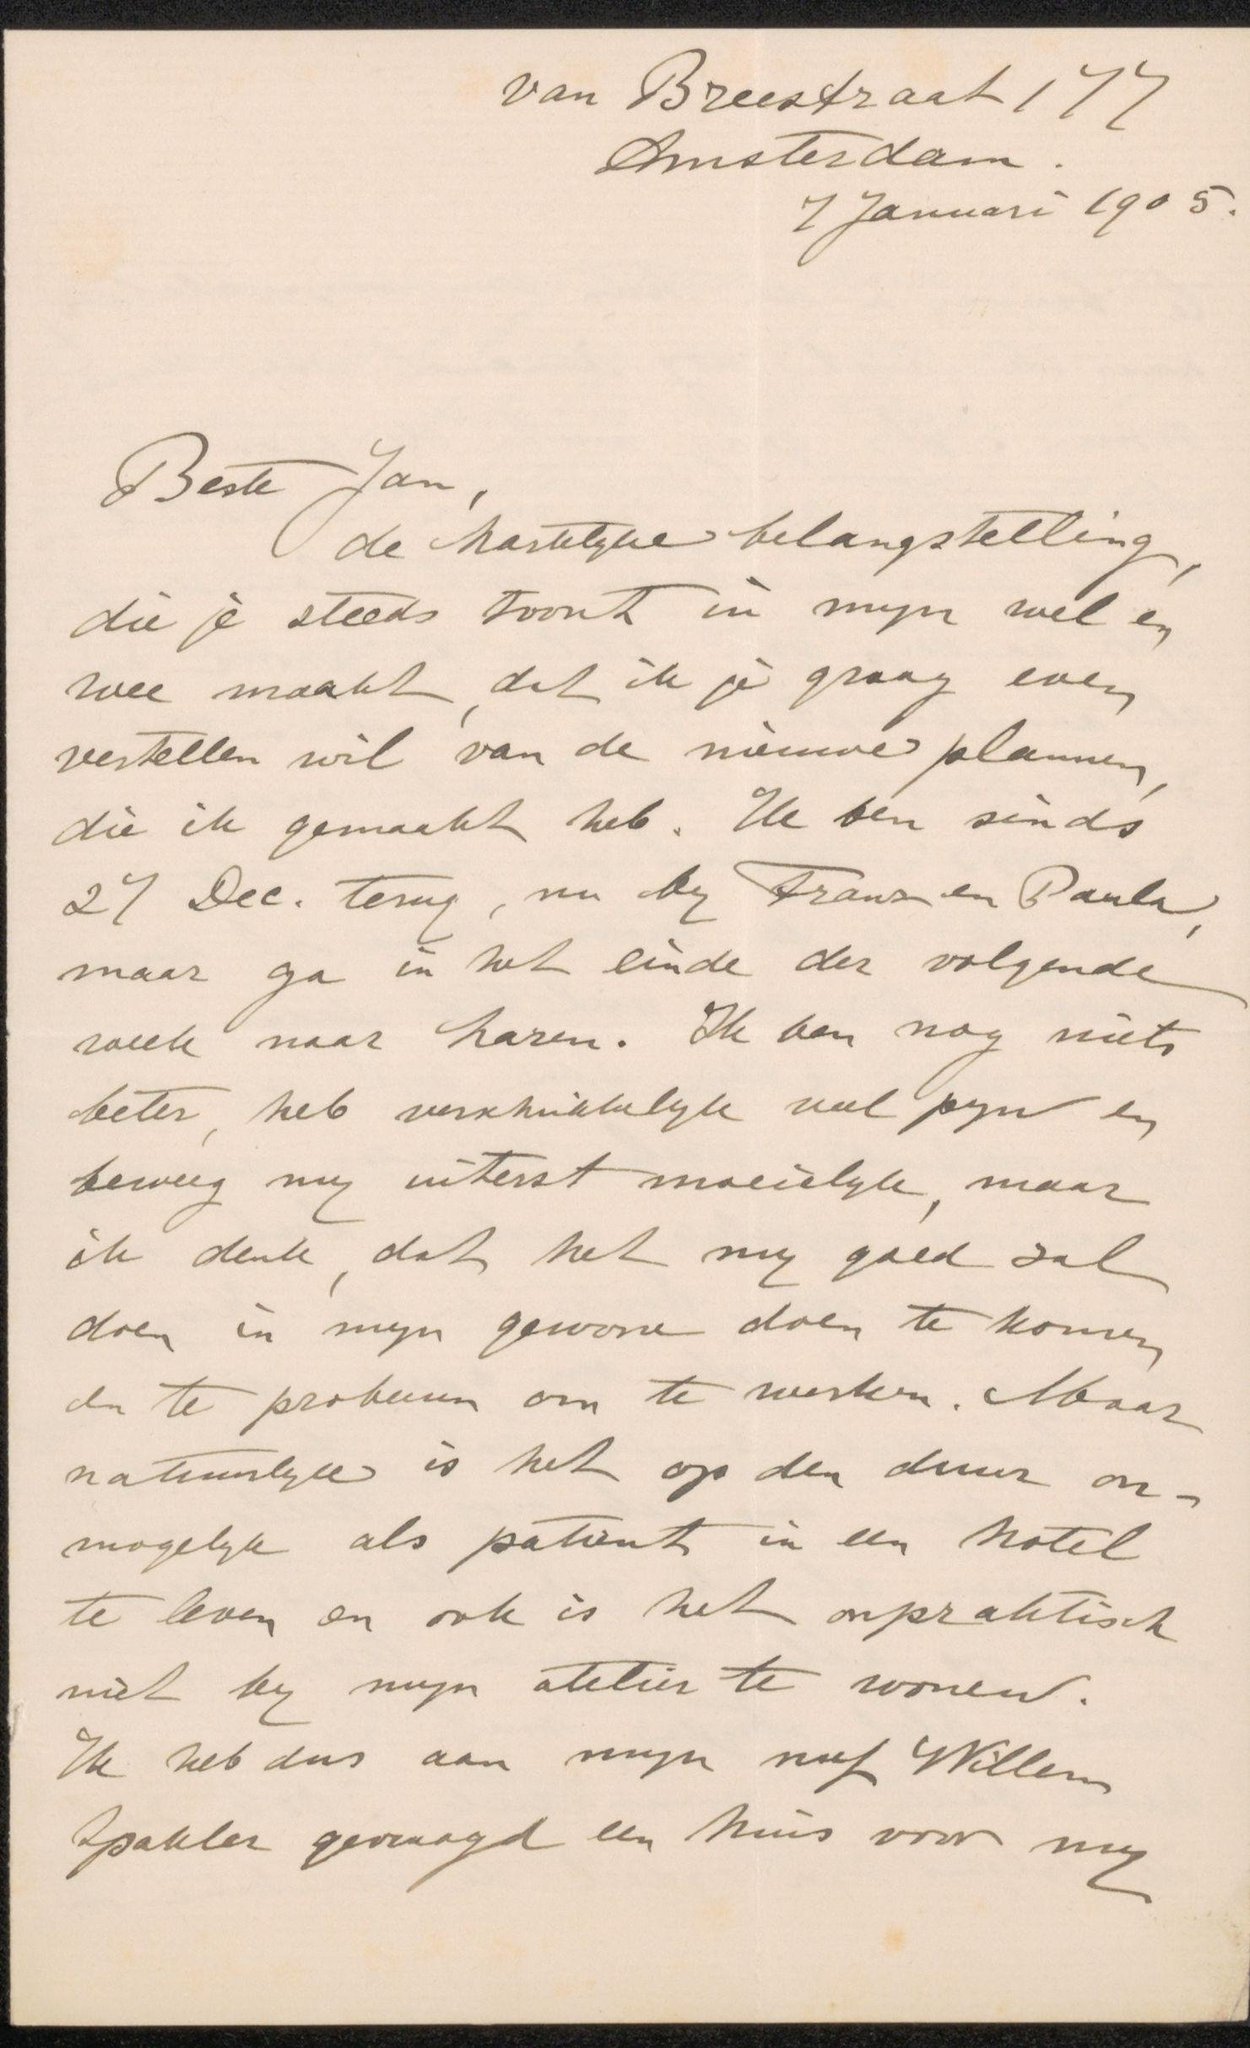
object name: letter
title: Brief aan Jan Veth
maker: wally moes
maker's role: draughtsman, print maker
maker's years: 1856-1918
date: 1905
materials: ink, paper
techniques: pen, writing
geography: amsterdam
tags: dordrecht, painter, designer, jan veth, jan schüller, painting (including book-illumination, miniature-painting), workshop, studio of the artist (in general), diseases, money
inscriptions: collector's mark: ‘RPK’